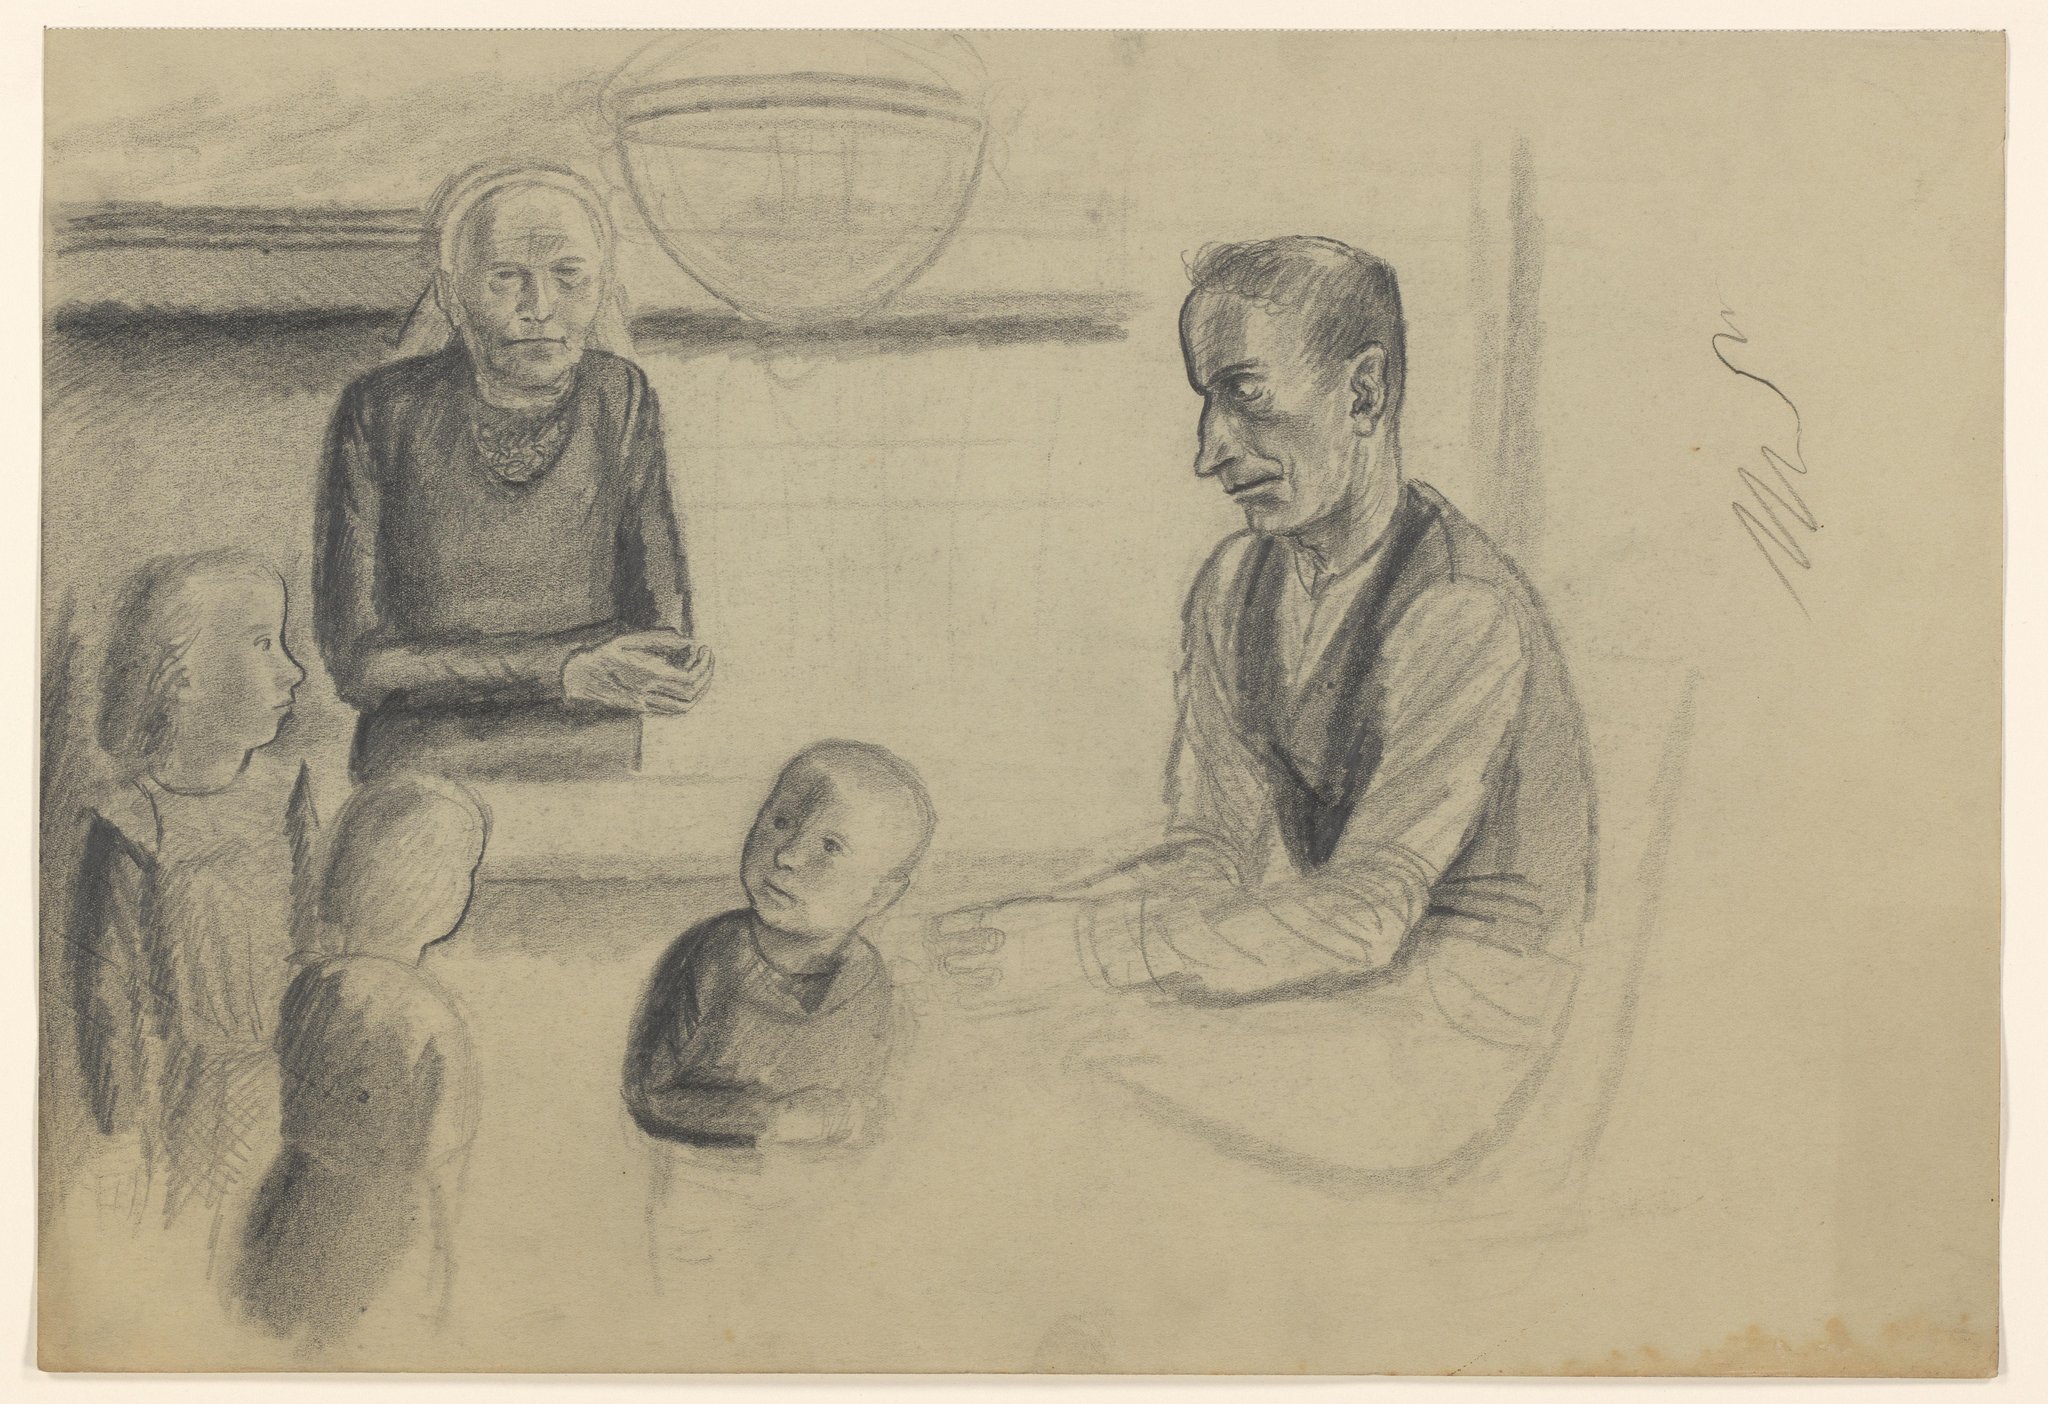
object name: drawing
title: Interieur met man, vrouw en drie kinderen rond een tafel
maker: henk henriët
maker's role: draughtsman, print maker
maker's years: 1903-1945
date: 1913-1945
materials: paper, pencil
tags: family life at home